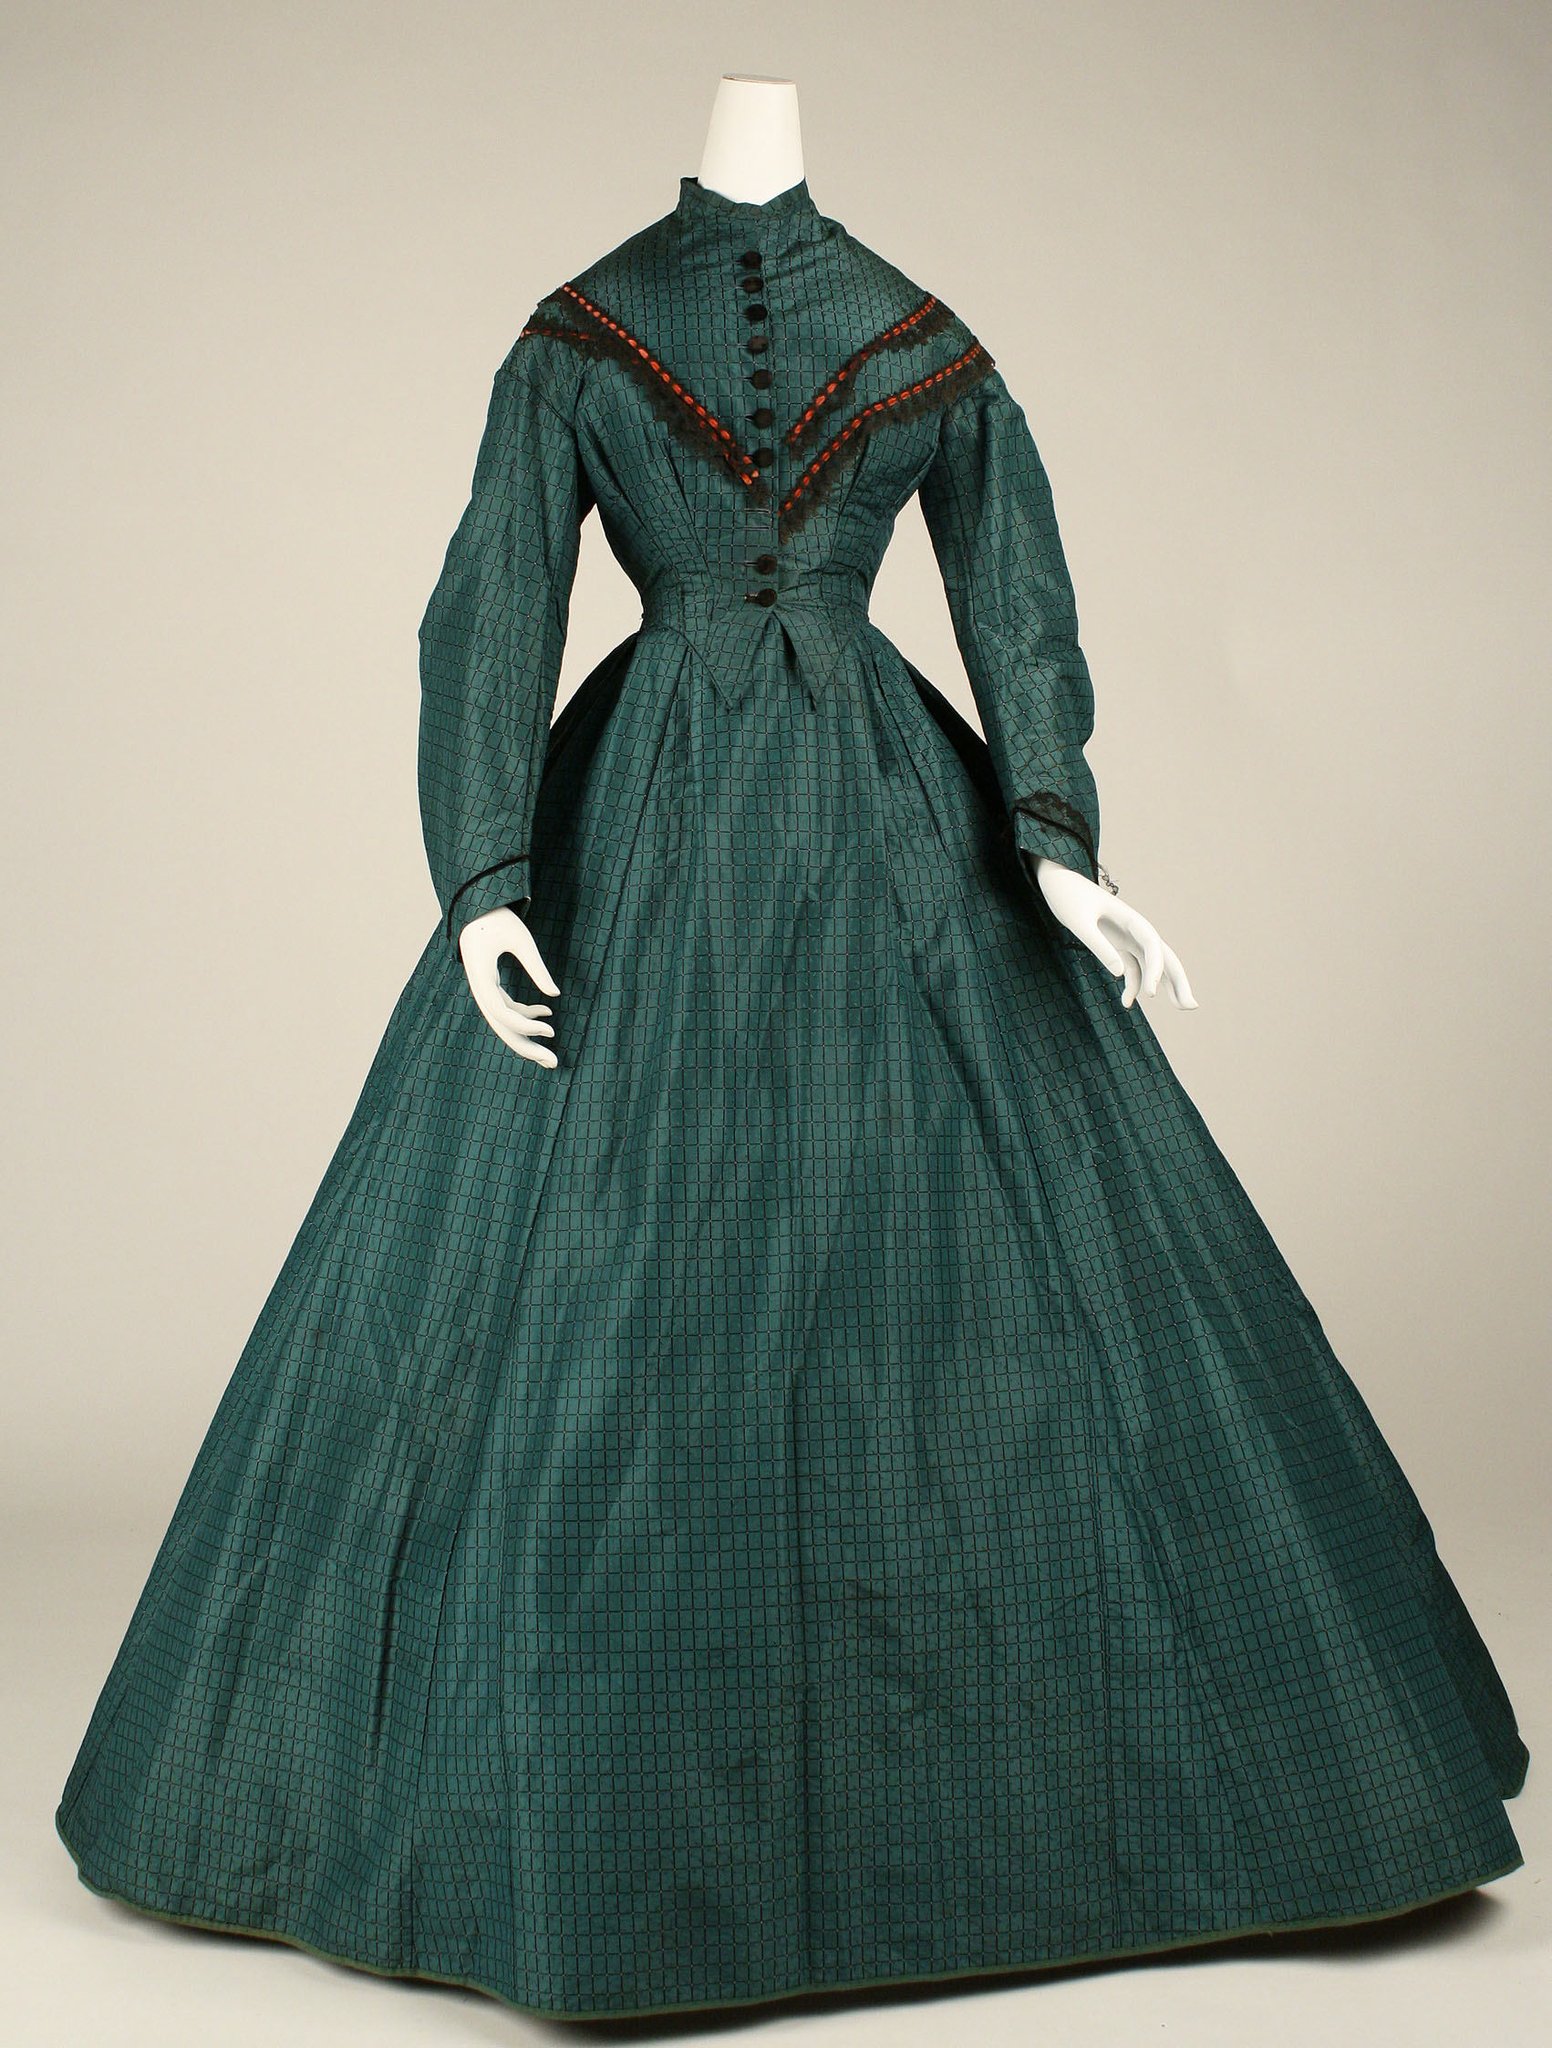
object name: dress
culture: american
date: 1863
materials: silk